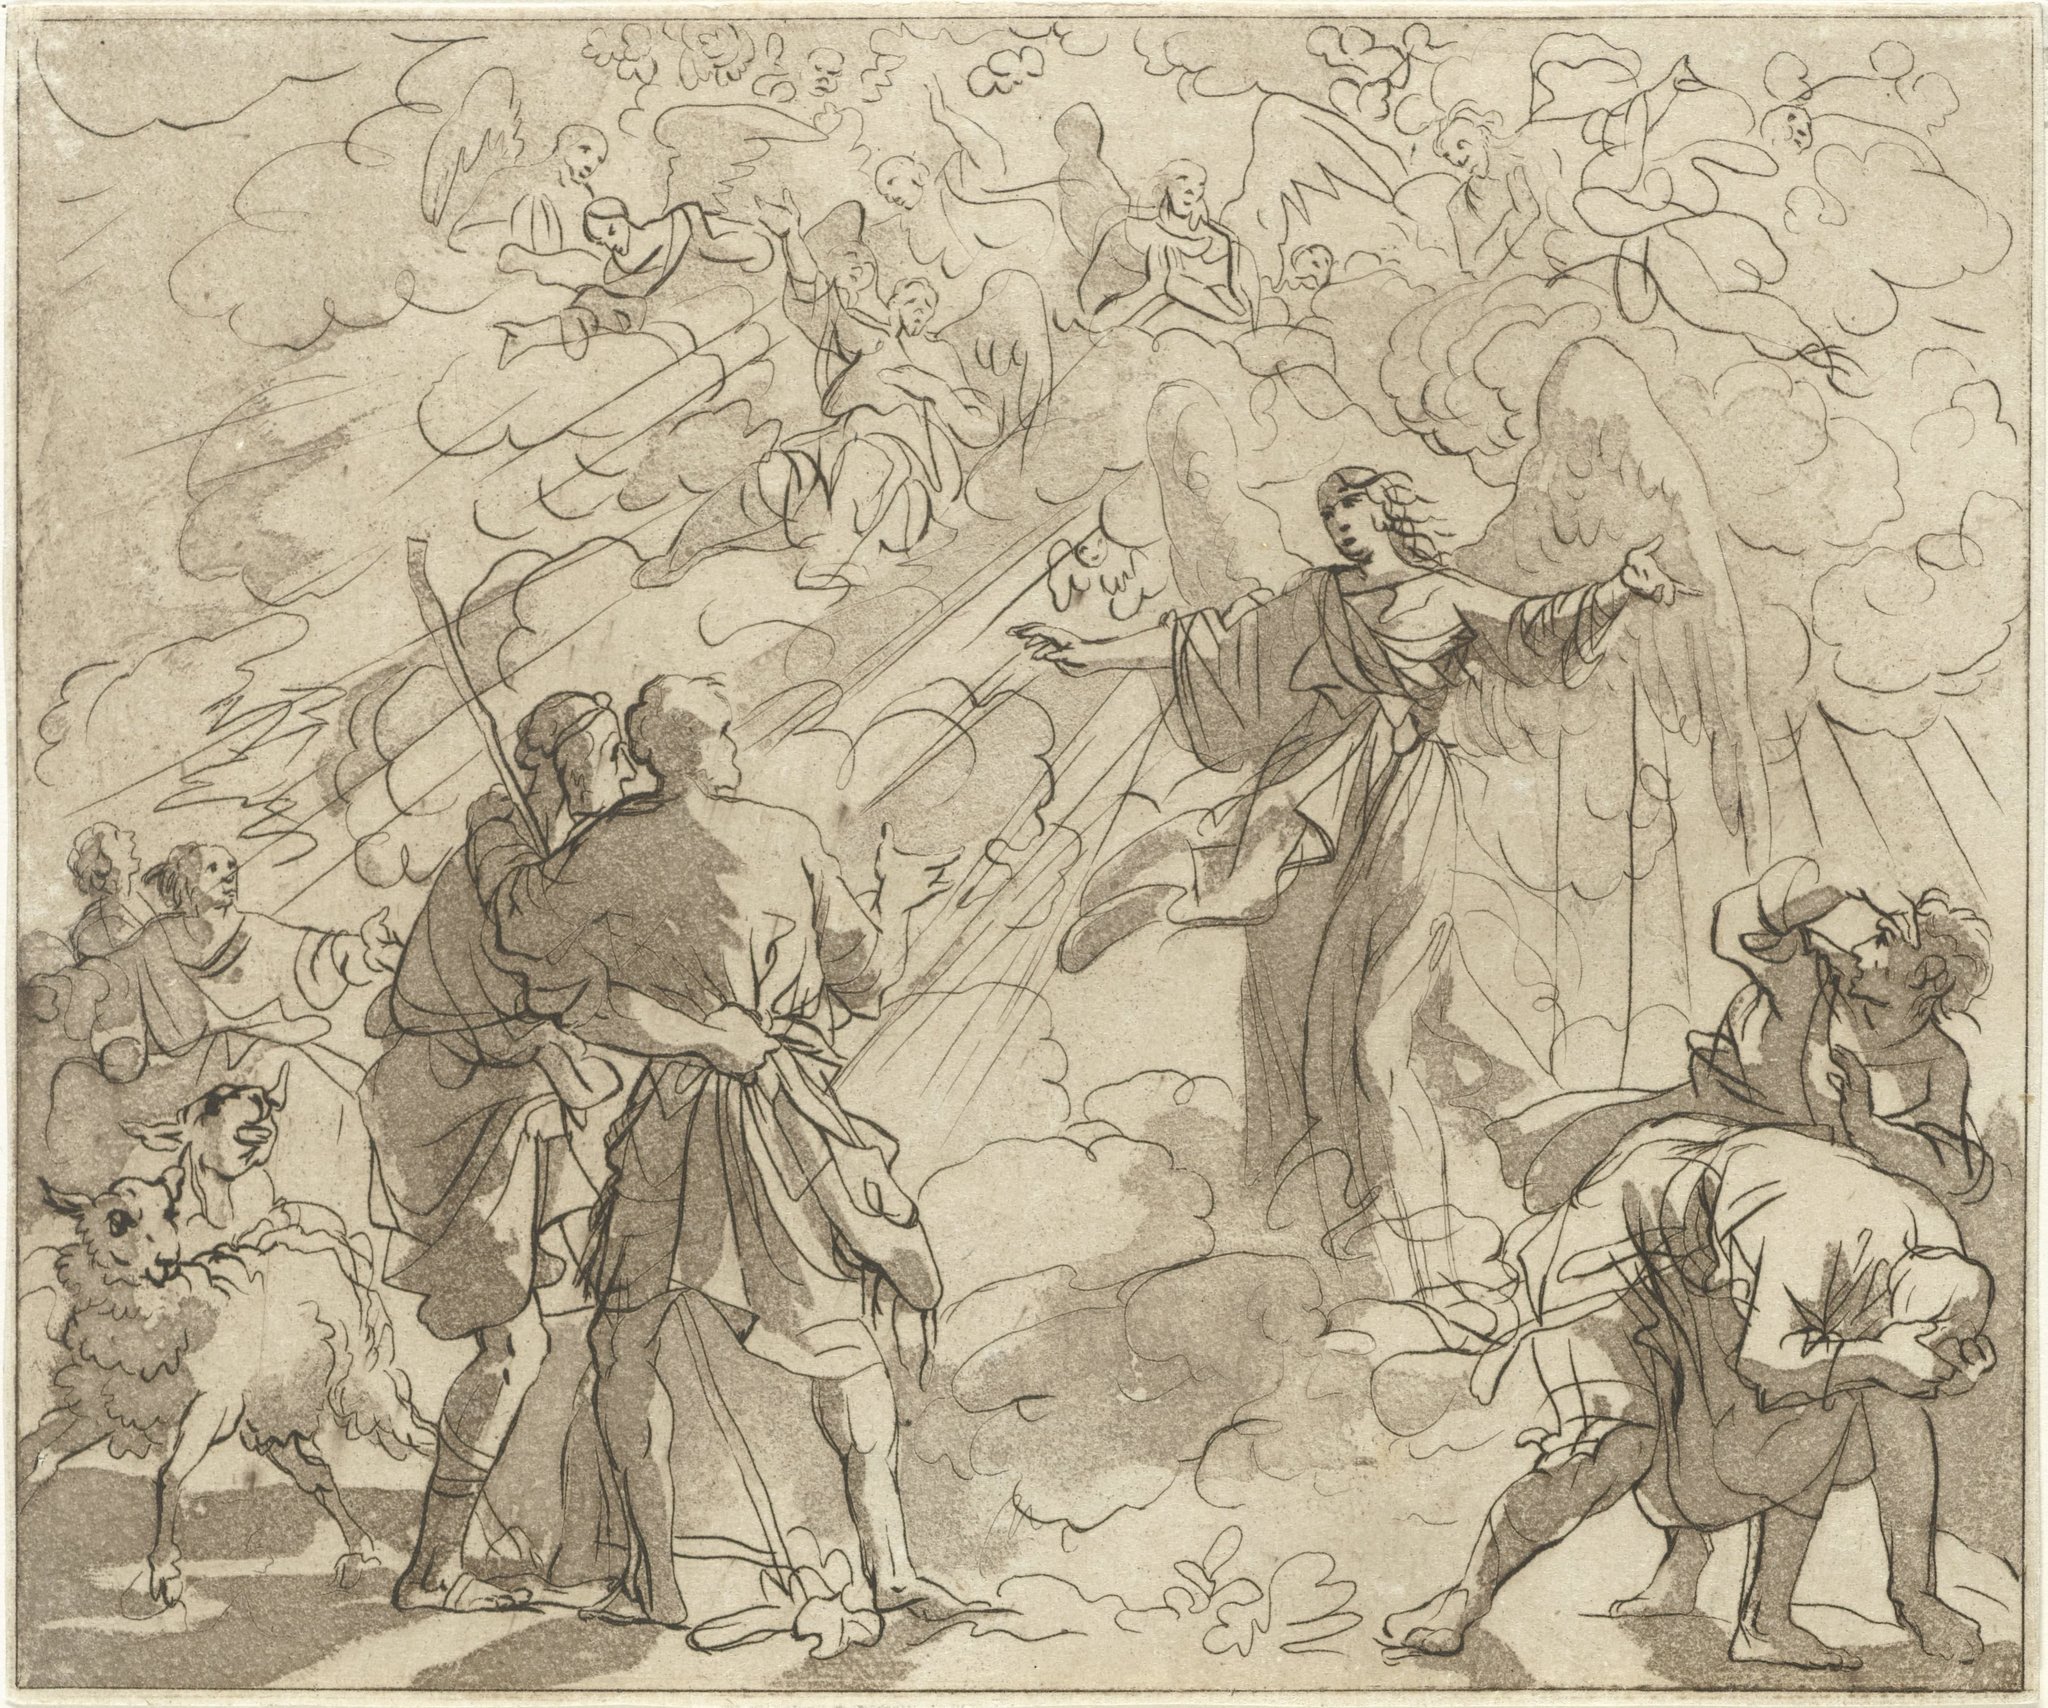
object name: print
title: Verkondiging aan de herders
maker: jacob ernst marcus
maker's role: draughtsman, print maker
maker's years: 1774-1826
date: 1784-1826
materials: paper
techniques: aquatint, etching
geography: amsterdam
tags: annunciation of christ's birth to the shepherds (and/or shepherdesses) at night; a host of singing angels in the air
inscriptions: collector's mark: Lugt 2228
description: De engel Gabriël verkondigt de geboorte van Christus aan de herders in het veld.